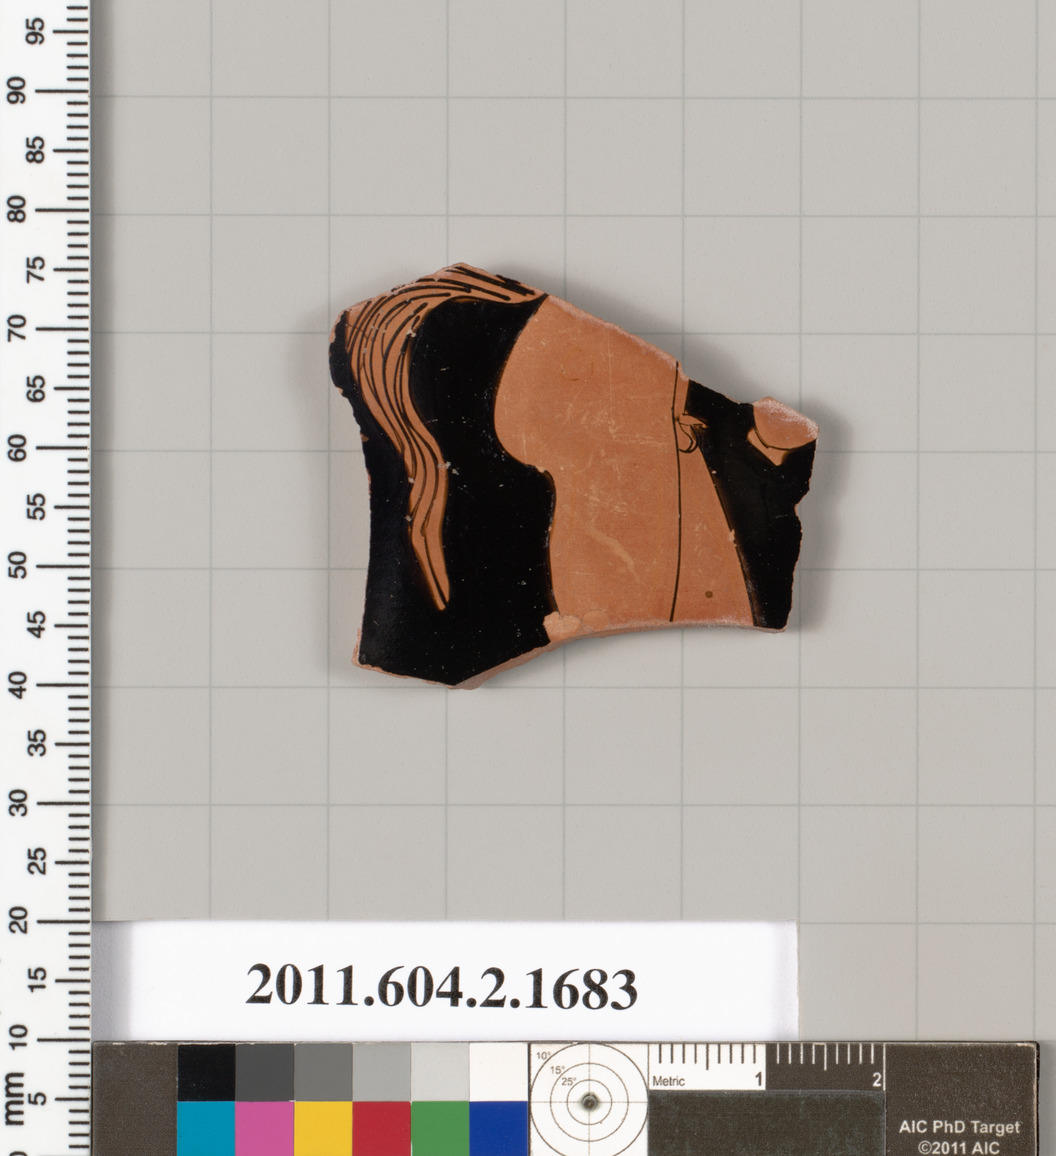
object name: skyphos fragment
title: Terracotta fragment of a skyphos (deep drinking cup)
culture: greek, attic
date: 480-470 BCE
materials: terracotta